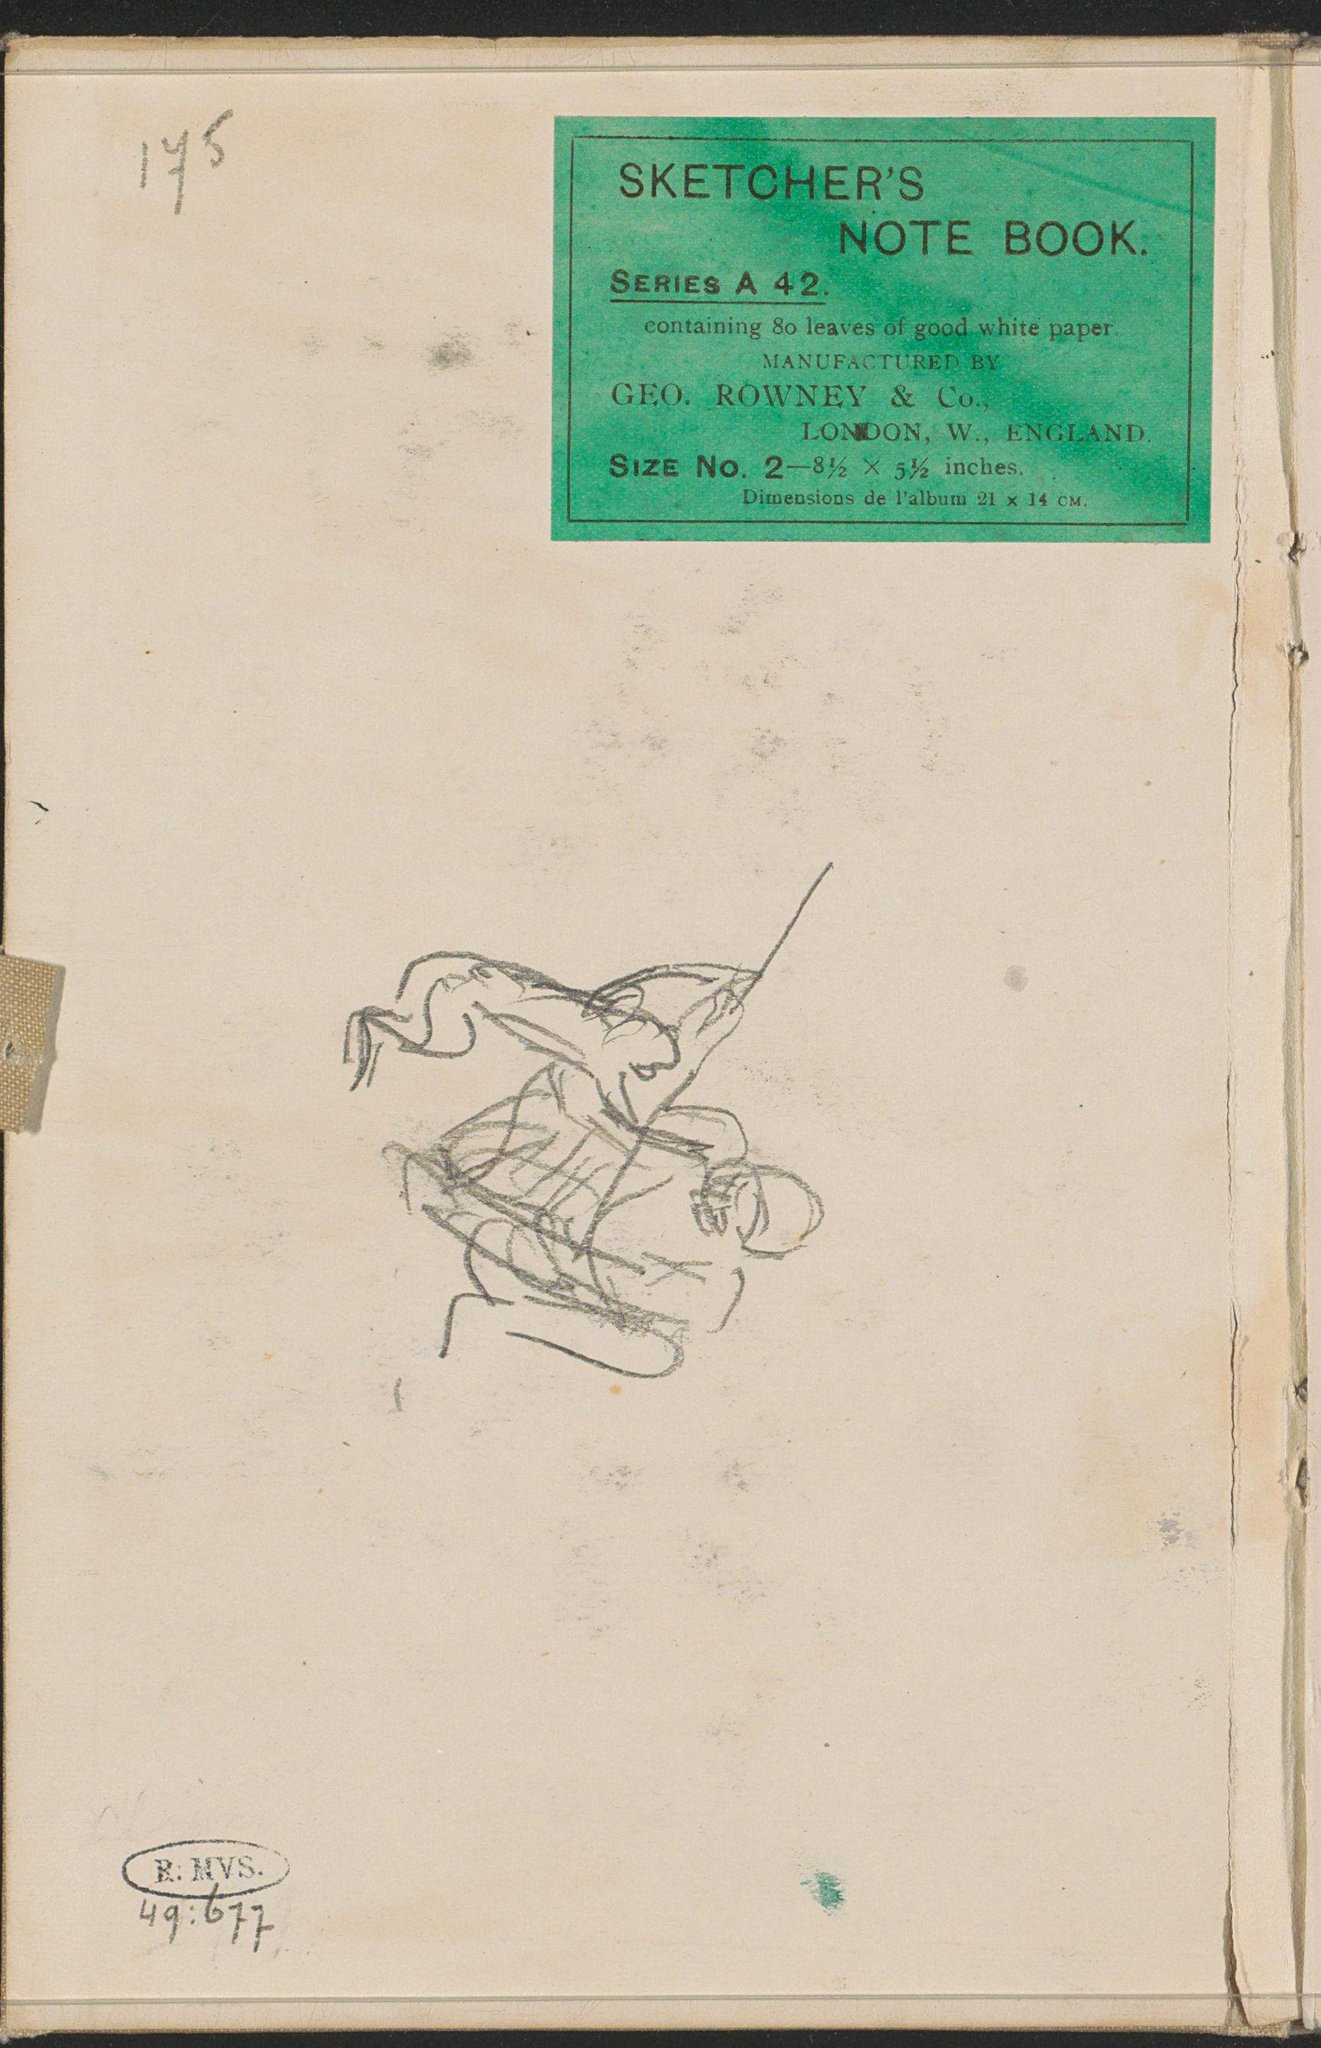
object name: sketchbook leaf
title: Gehurkte man met een aap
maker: marius bauer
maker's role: draughtsman, print maker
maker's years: 1867-1932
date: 1923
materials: paper, pencil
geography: morocco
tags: monkeys, apes, squatting, crouching figure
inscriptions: collector's mark: Lugt 2228, annotation: ‘175’, retailer's mark: ‘SKETCHER'S/ NOTE BOOK/ Series A 42/ containing 80 leaves of good white paper./ MANUFACTURED BY/ GEO. ROWNEY & Co./ LONDON, W., ENGLAND./ SIZE No. 2 - 8 1/2 x 5 1/2 inches./ Dimensions de l'album 21 x 14 cm.’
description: Voorste schutblad uit een schetsboek met 66 bladen.